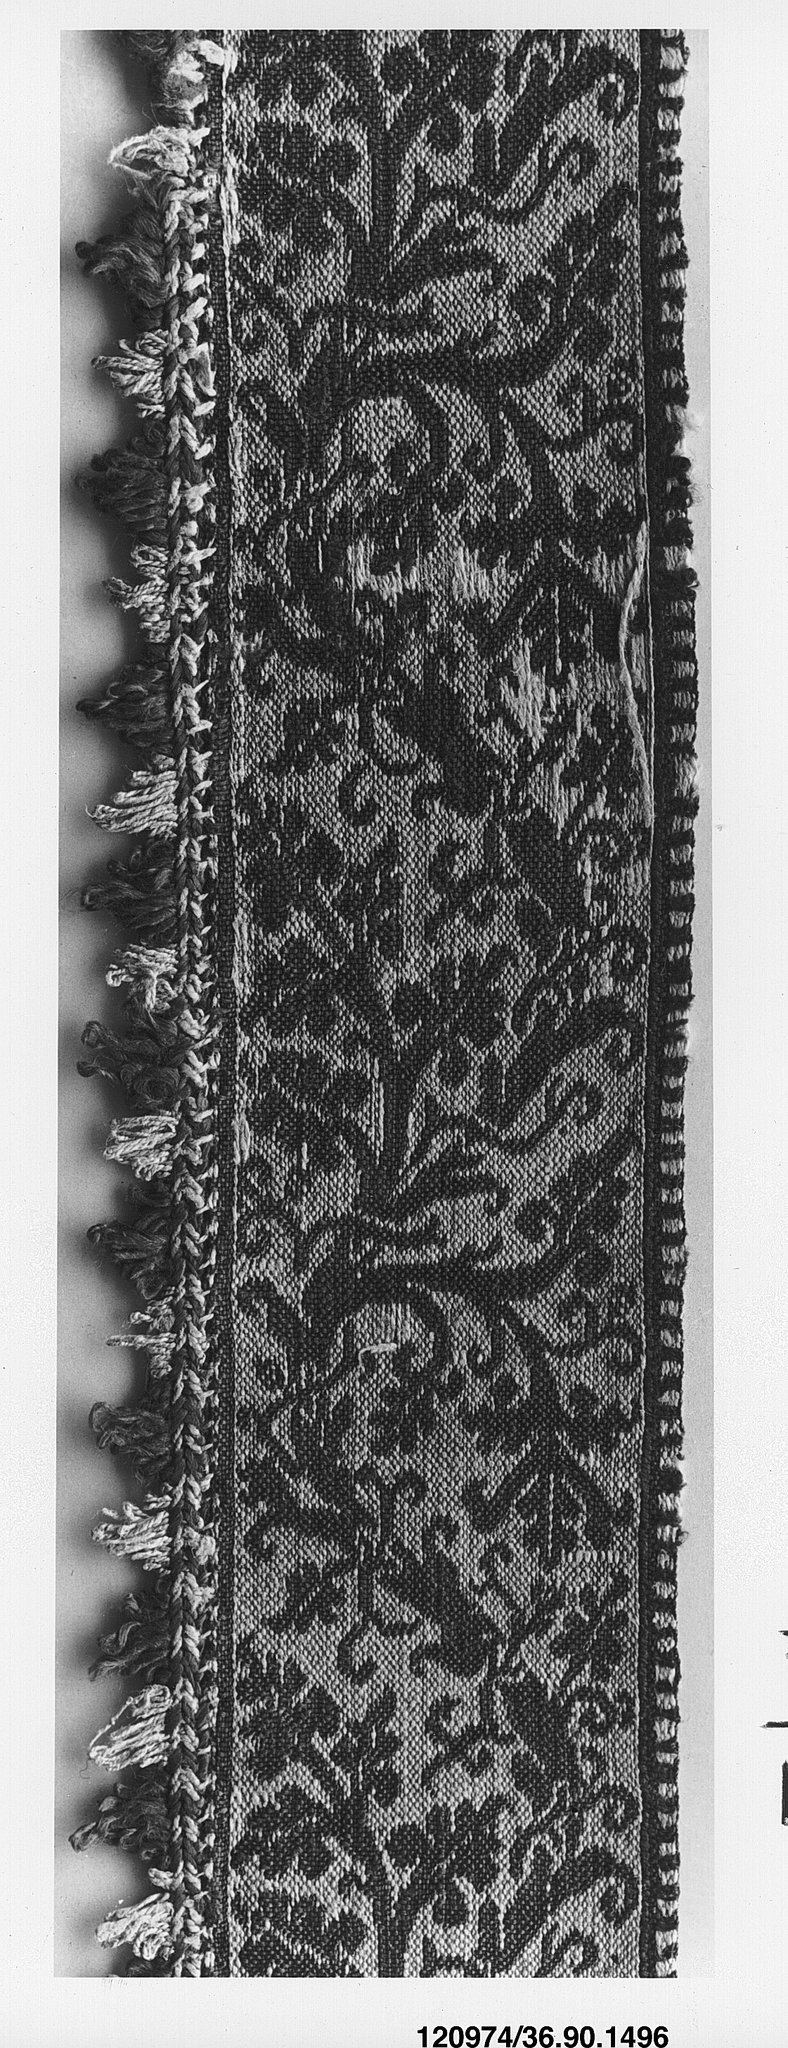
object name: piece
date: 1501-1700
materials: silk